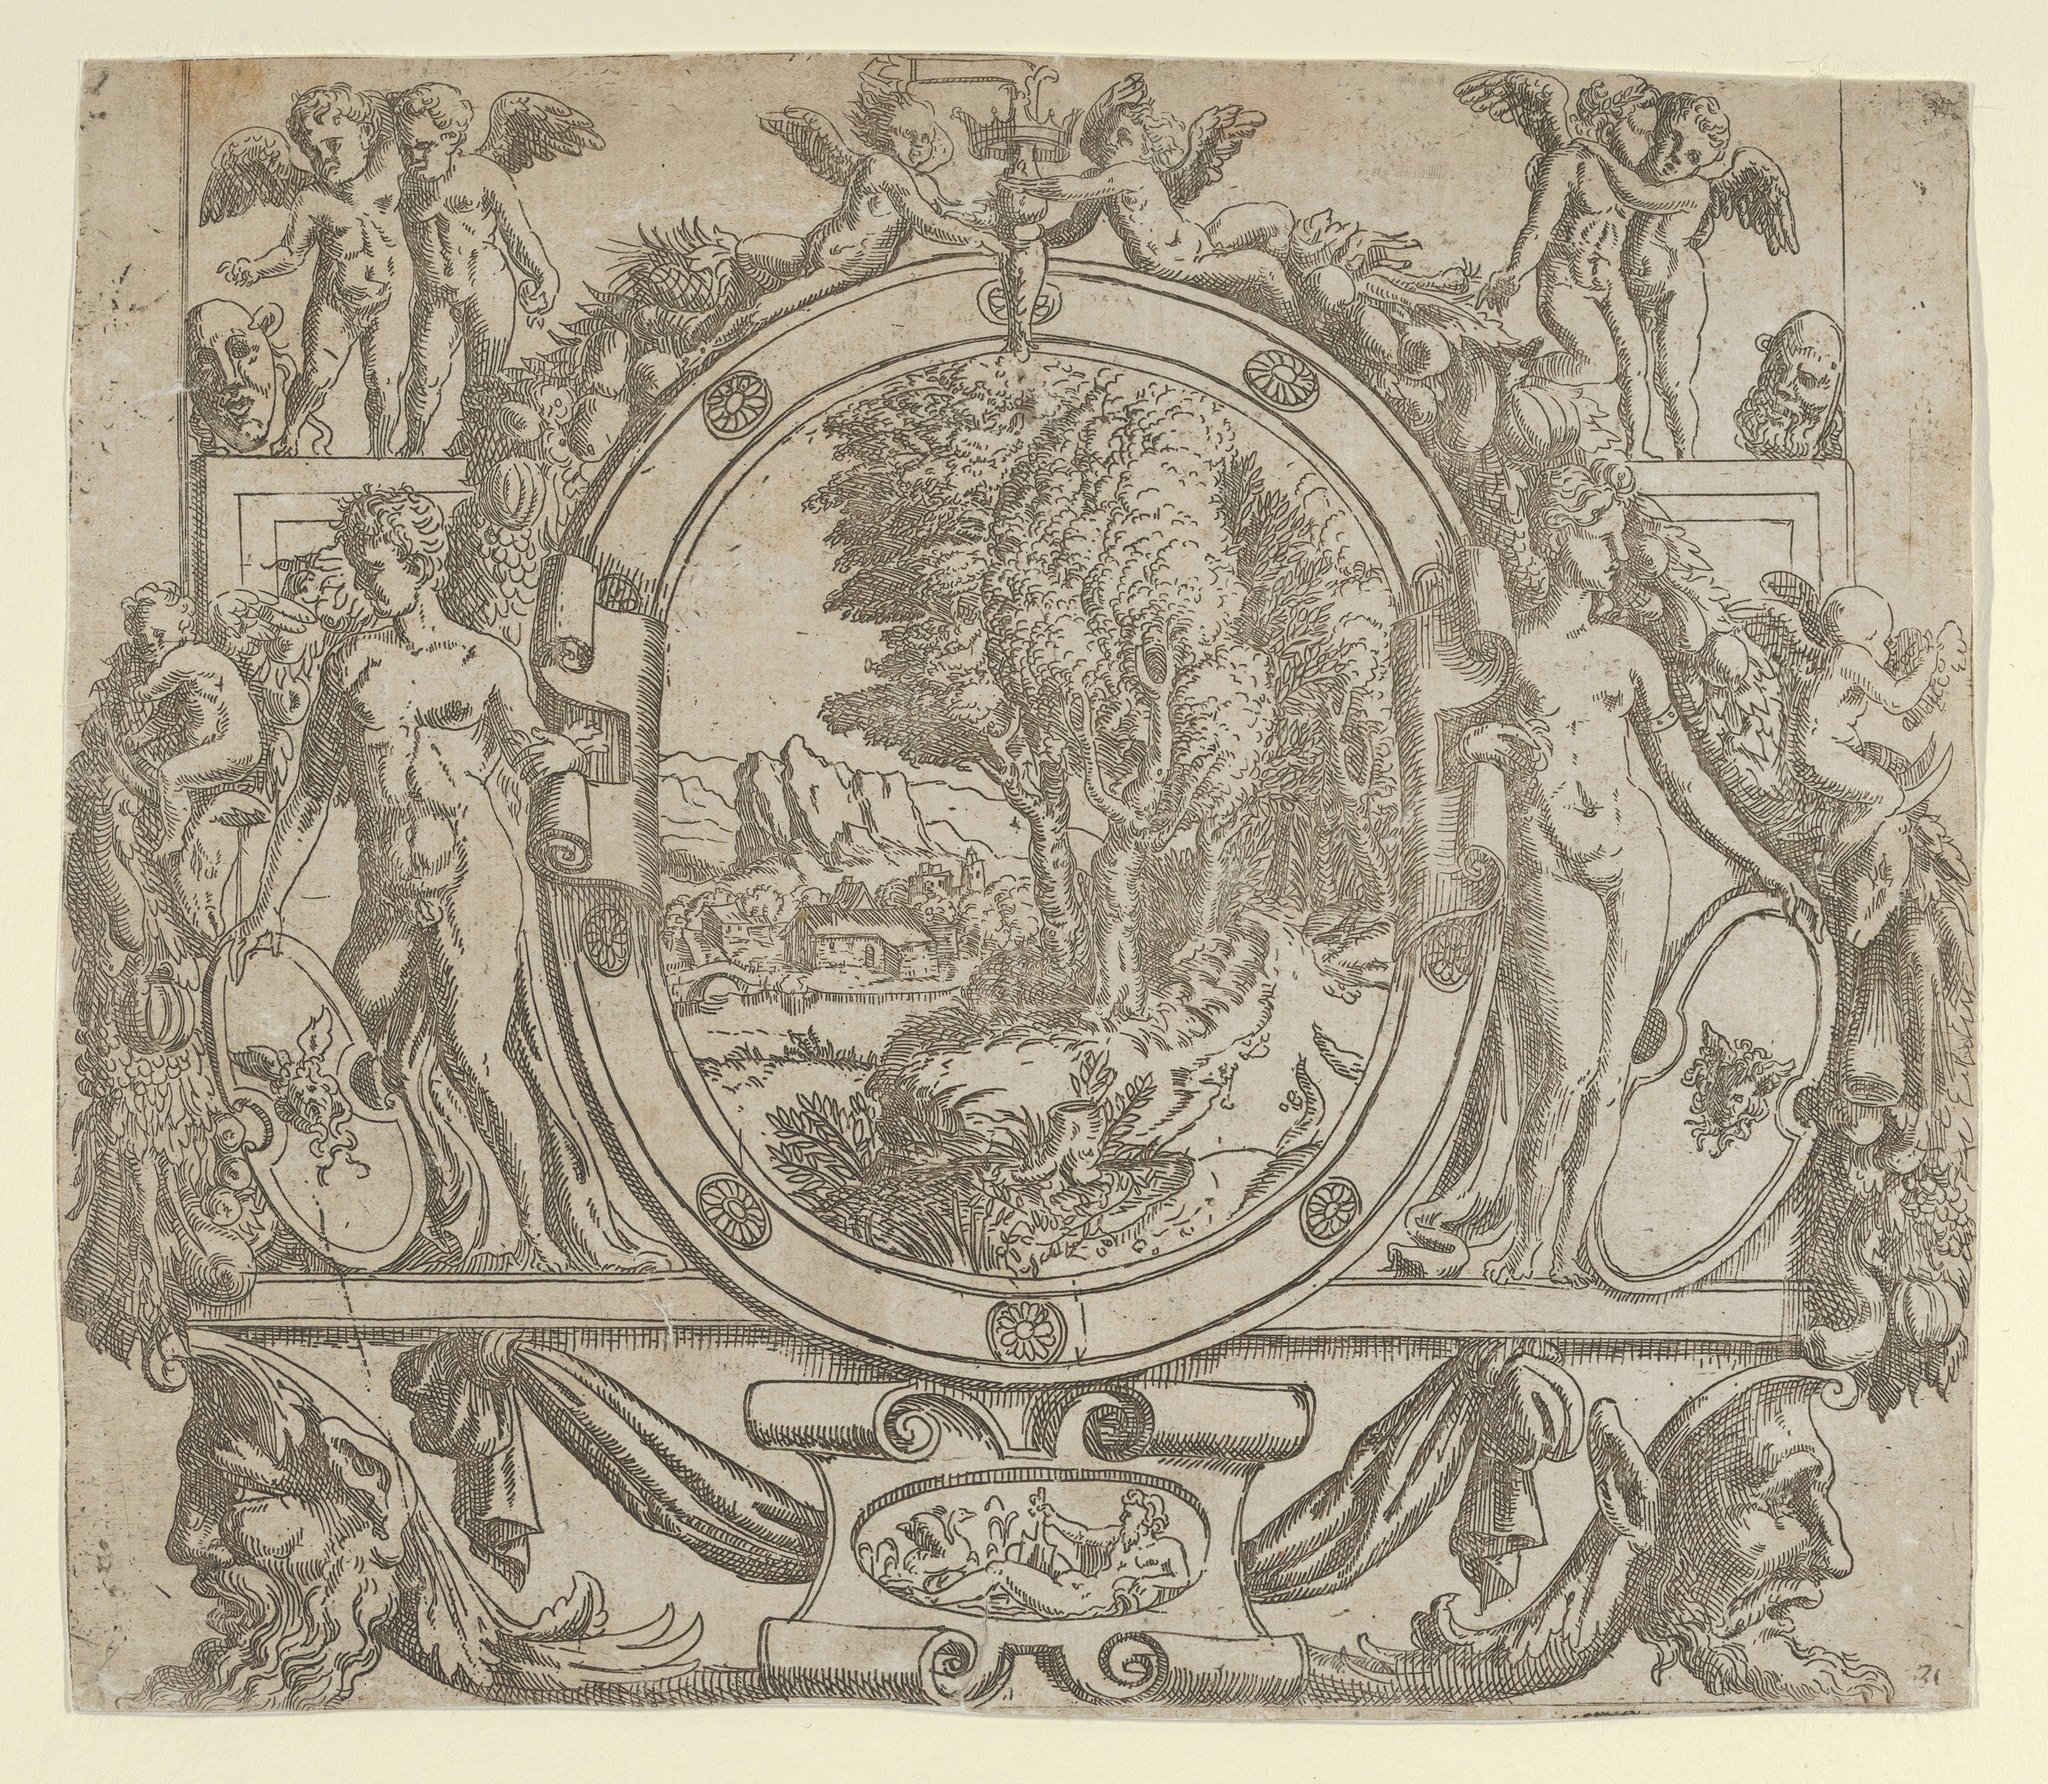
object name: print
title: Oval landscape in an ornate frame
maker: anonymous, french, school of fontainebleau, 16th century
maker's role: artist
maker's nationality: french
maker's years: 1500-1600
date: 1542-1545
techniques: etching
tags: male nudes,female nudes,landscapes